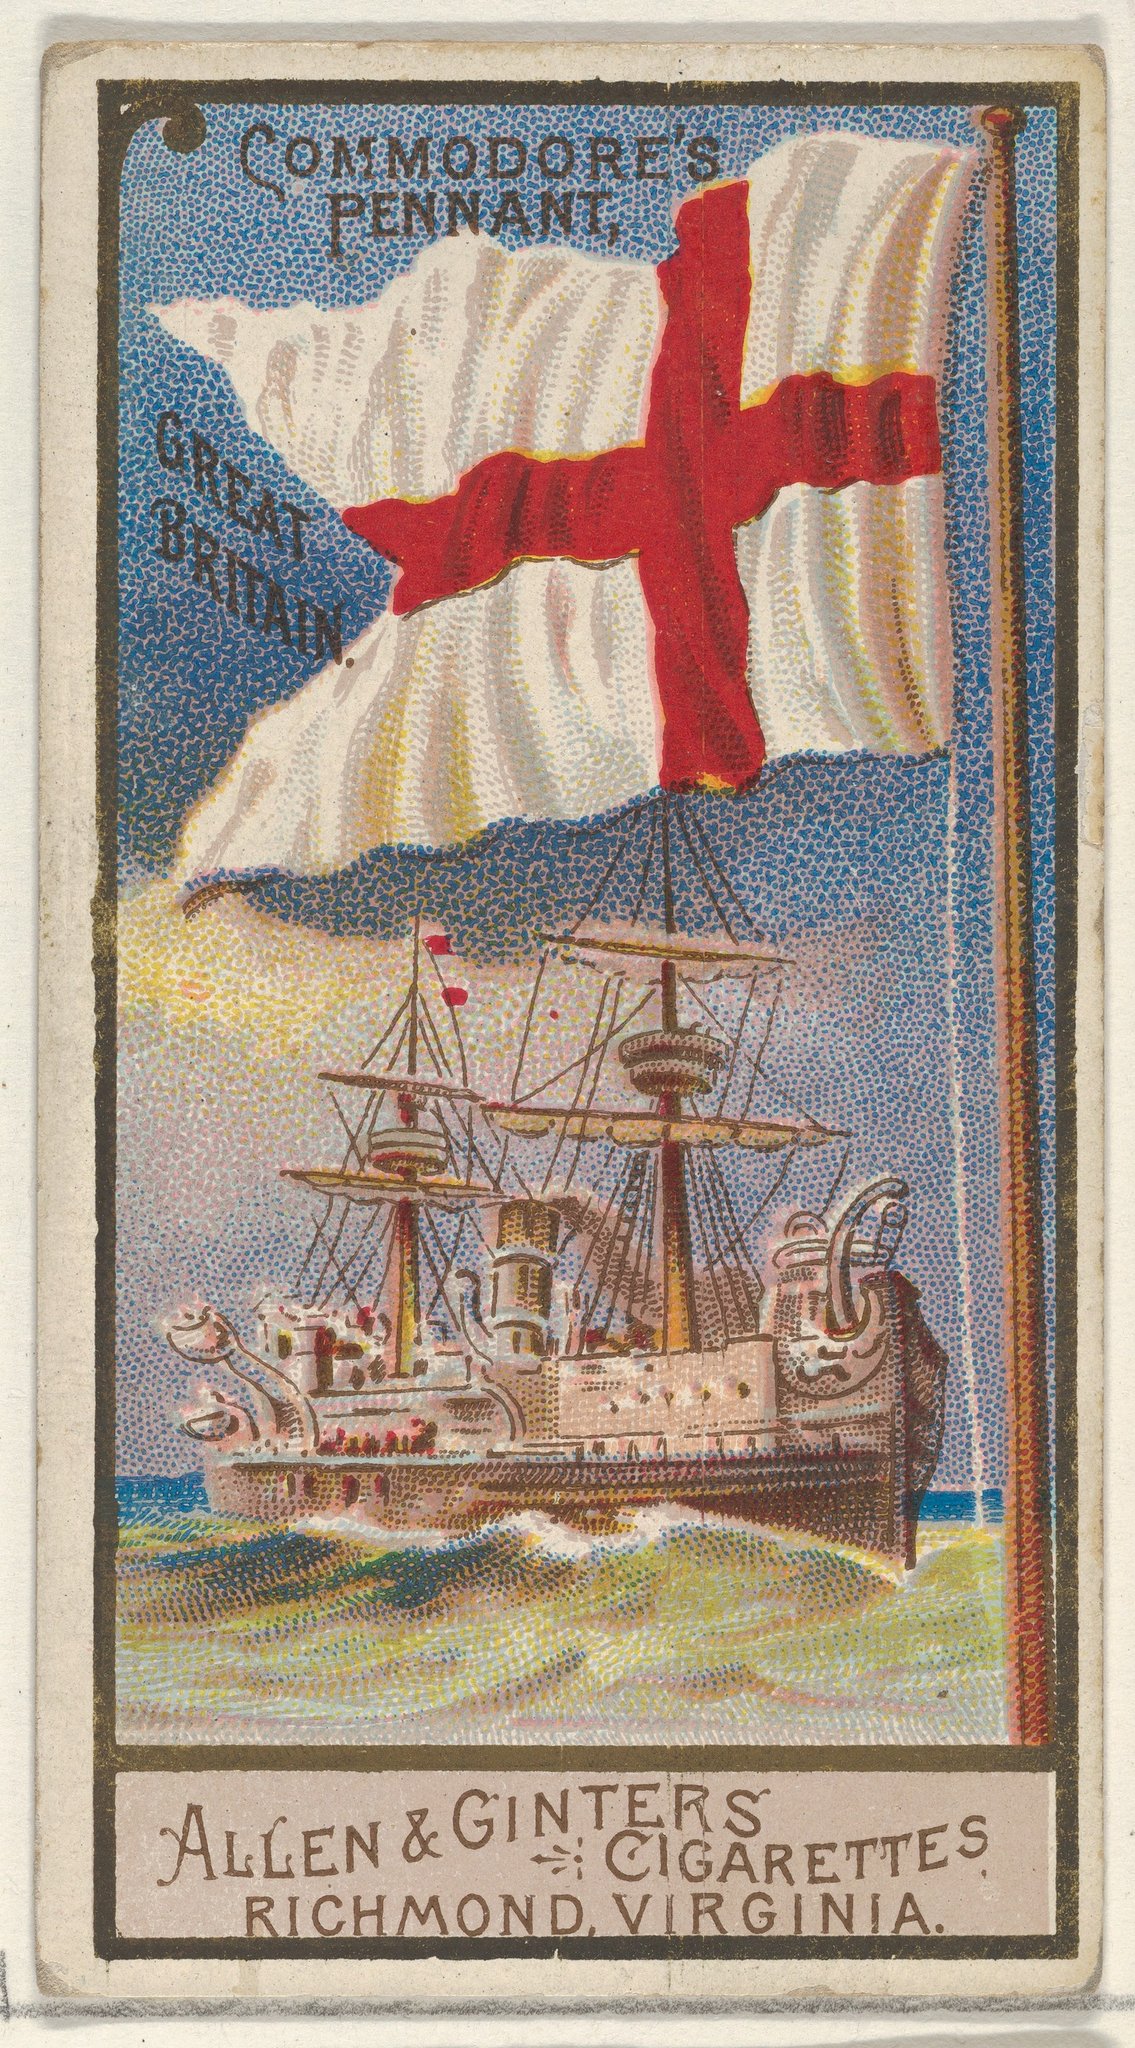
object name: print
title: Commodore's Pennant, Great Britain, from the Naval Flags series (N17) for Allen & Ginter Cigarettes Brands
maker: allen & ginter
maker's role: publisher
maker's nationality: american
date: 1888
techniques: color lithograph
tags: flags,ships